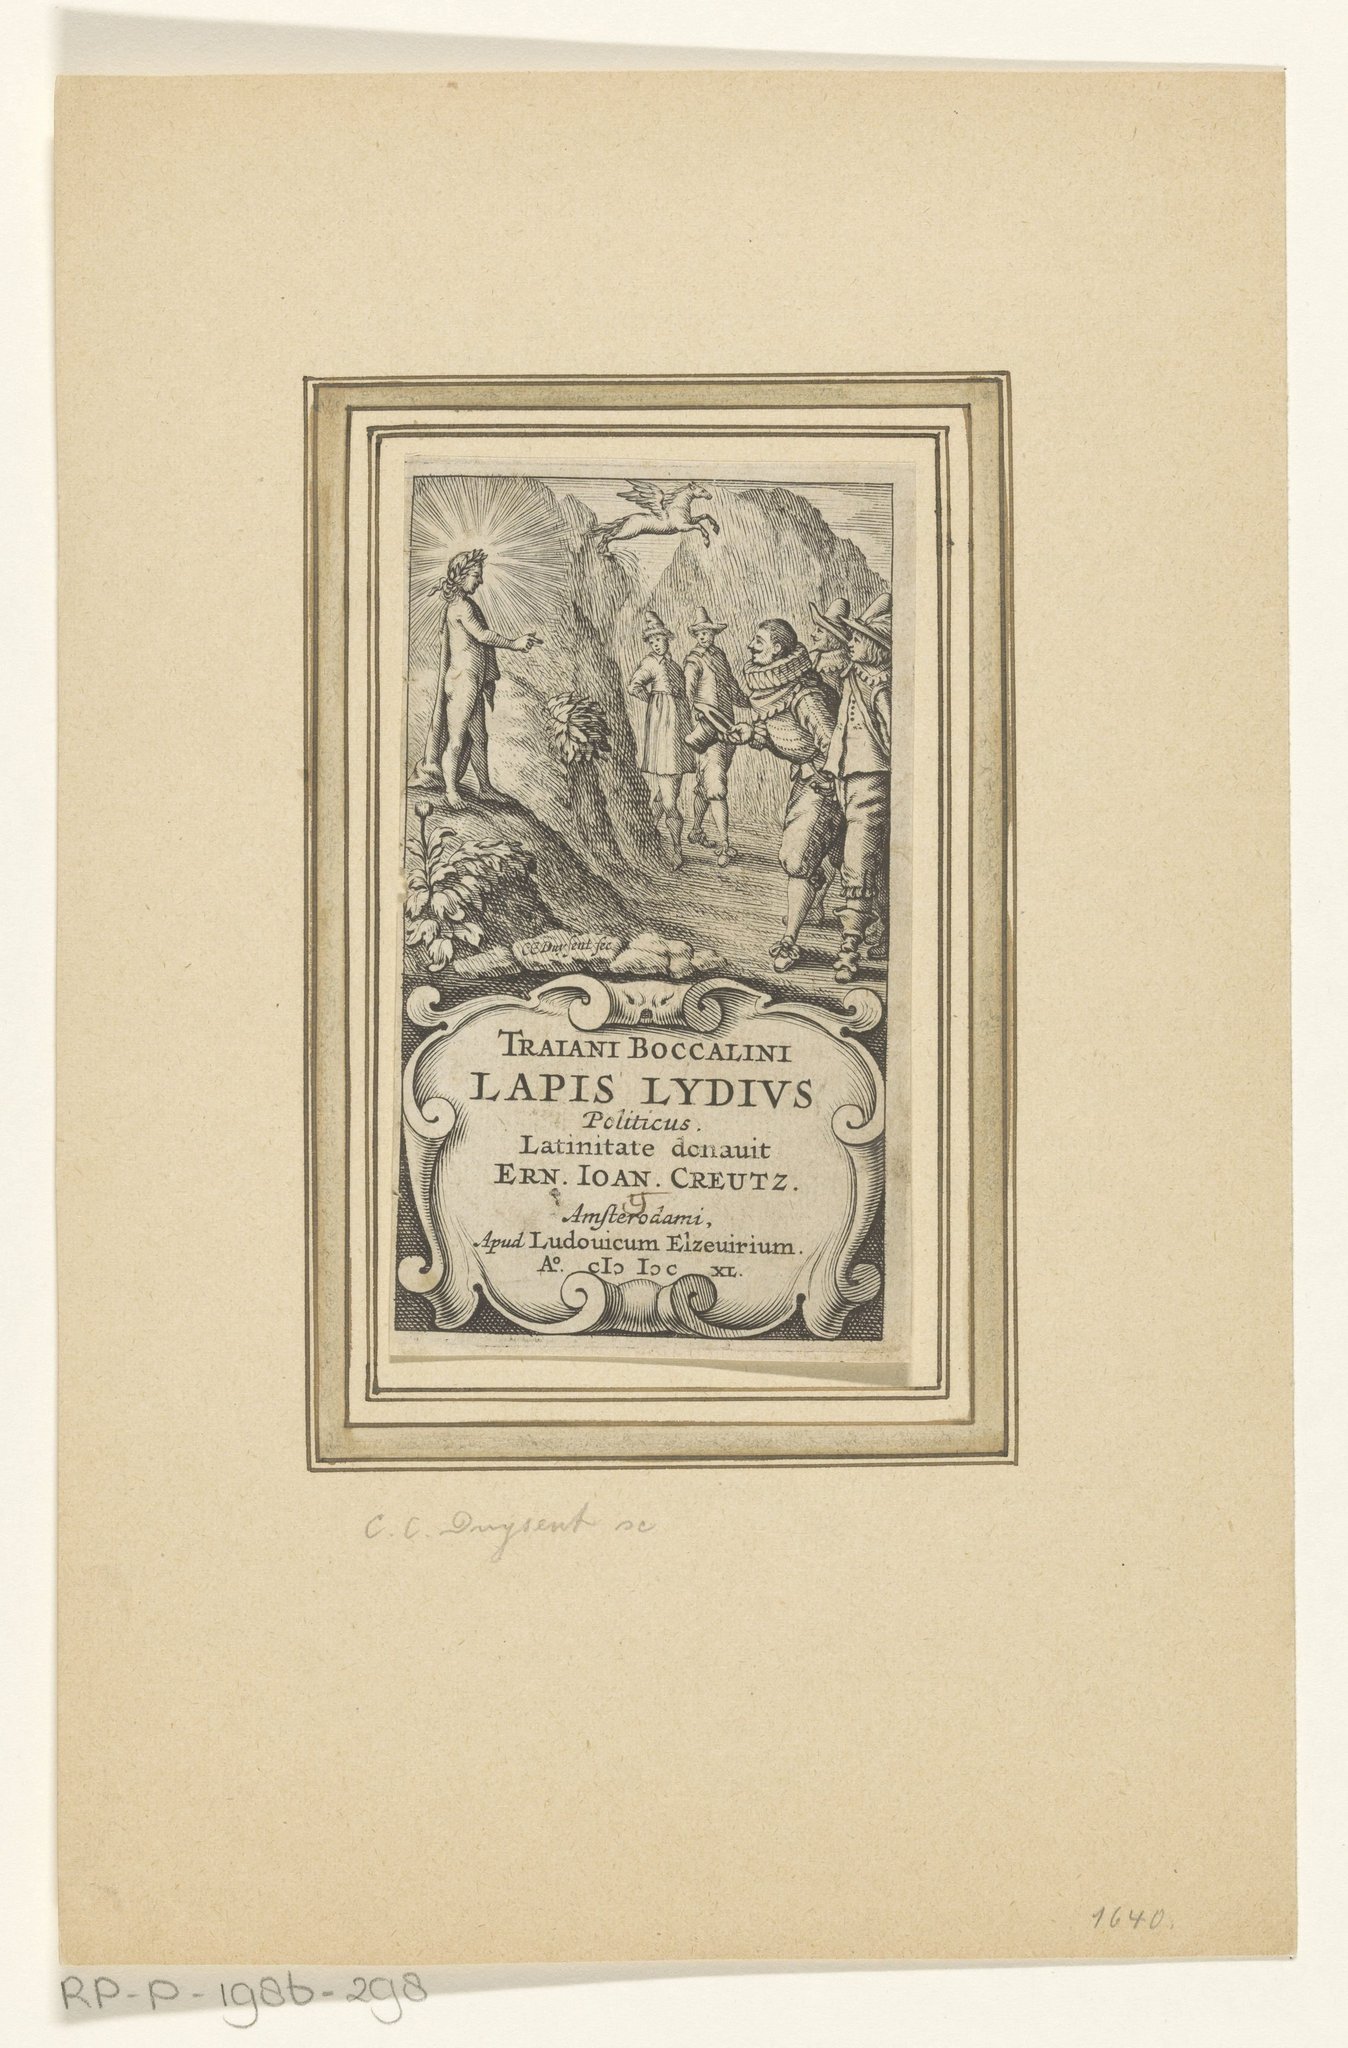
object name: titelblad, titelpagina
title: Drie mannen buigen voor Apollo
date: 1640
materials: paper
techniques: etching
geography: amsterdam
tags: bending figure, (story of) apollo (phoebus)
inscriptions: collector's mark: Lugt 2760, collector's mark: Lugt 2228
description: Drie mannen komen bij de zonnegod Apollo die op een heuvel staat. De middelste man buigt voor de god. In de lucht het gevleugeld paard Pegasus. In een cartouche de titel.